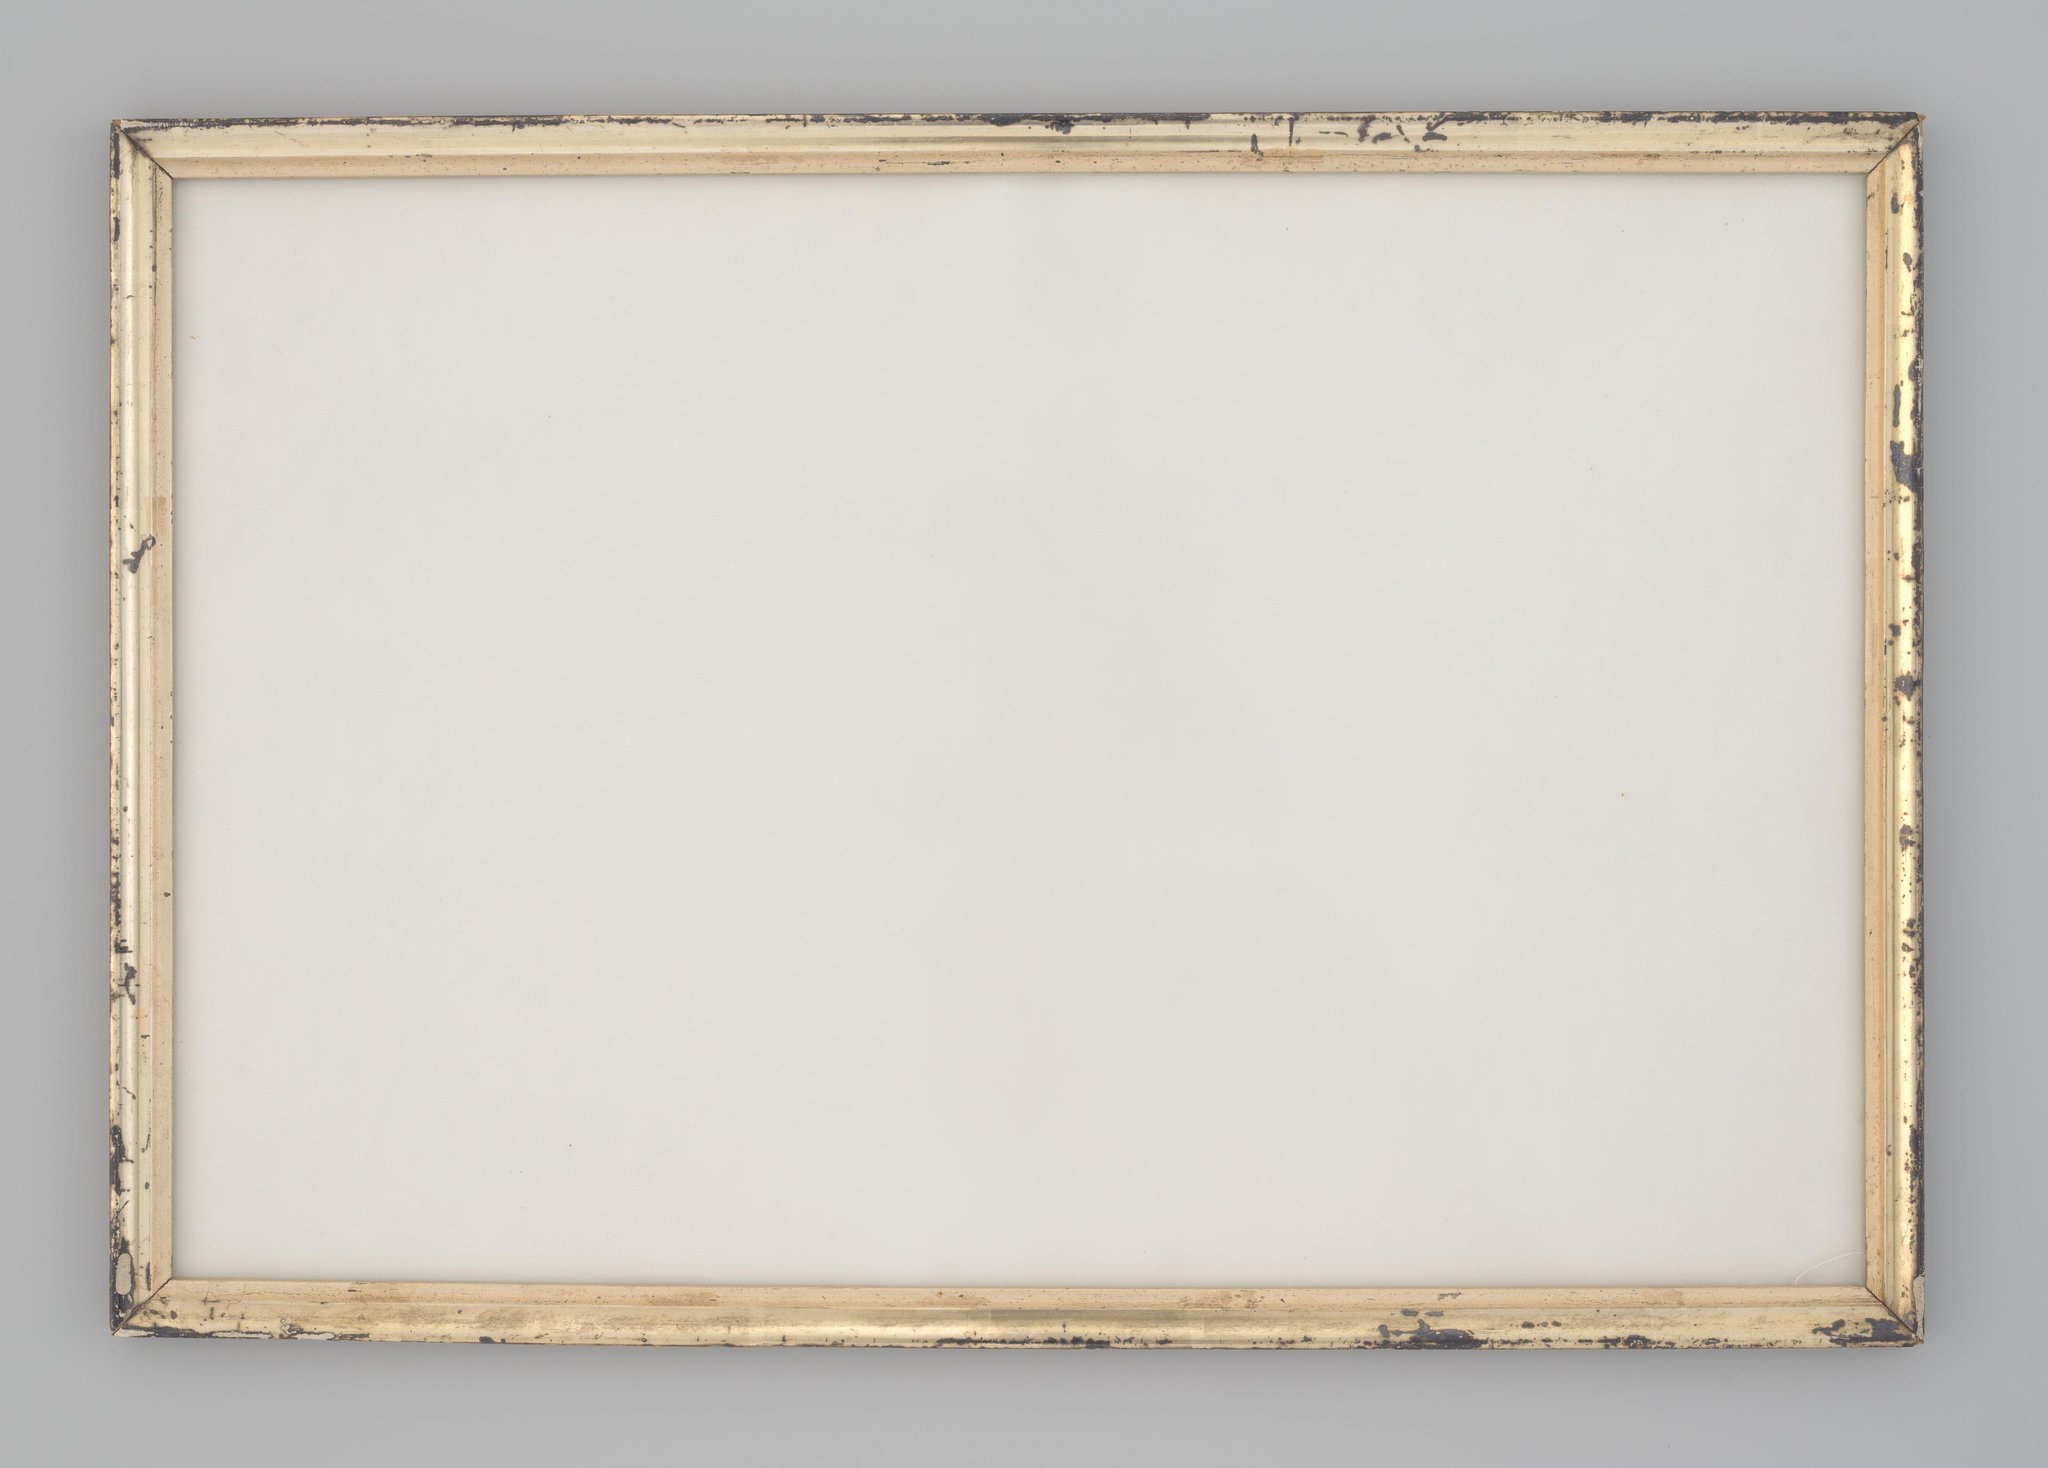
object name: frame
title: Picture Frame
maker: Anonymous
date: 1870-1879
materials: cardboard, glass, gypsum, wood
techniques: gilding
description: Lijst bij foto van een draailicht voor vuurtoren